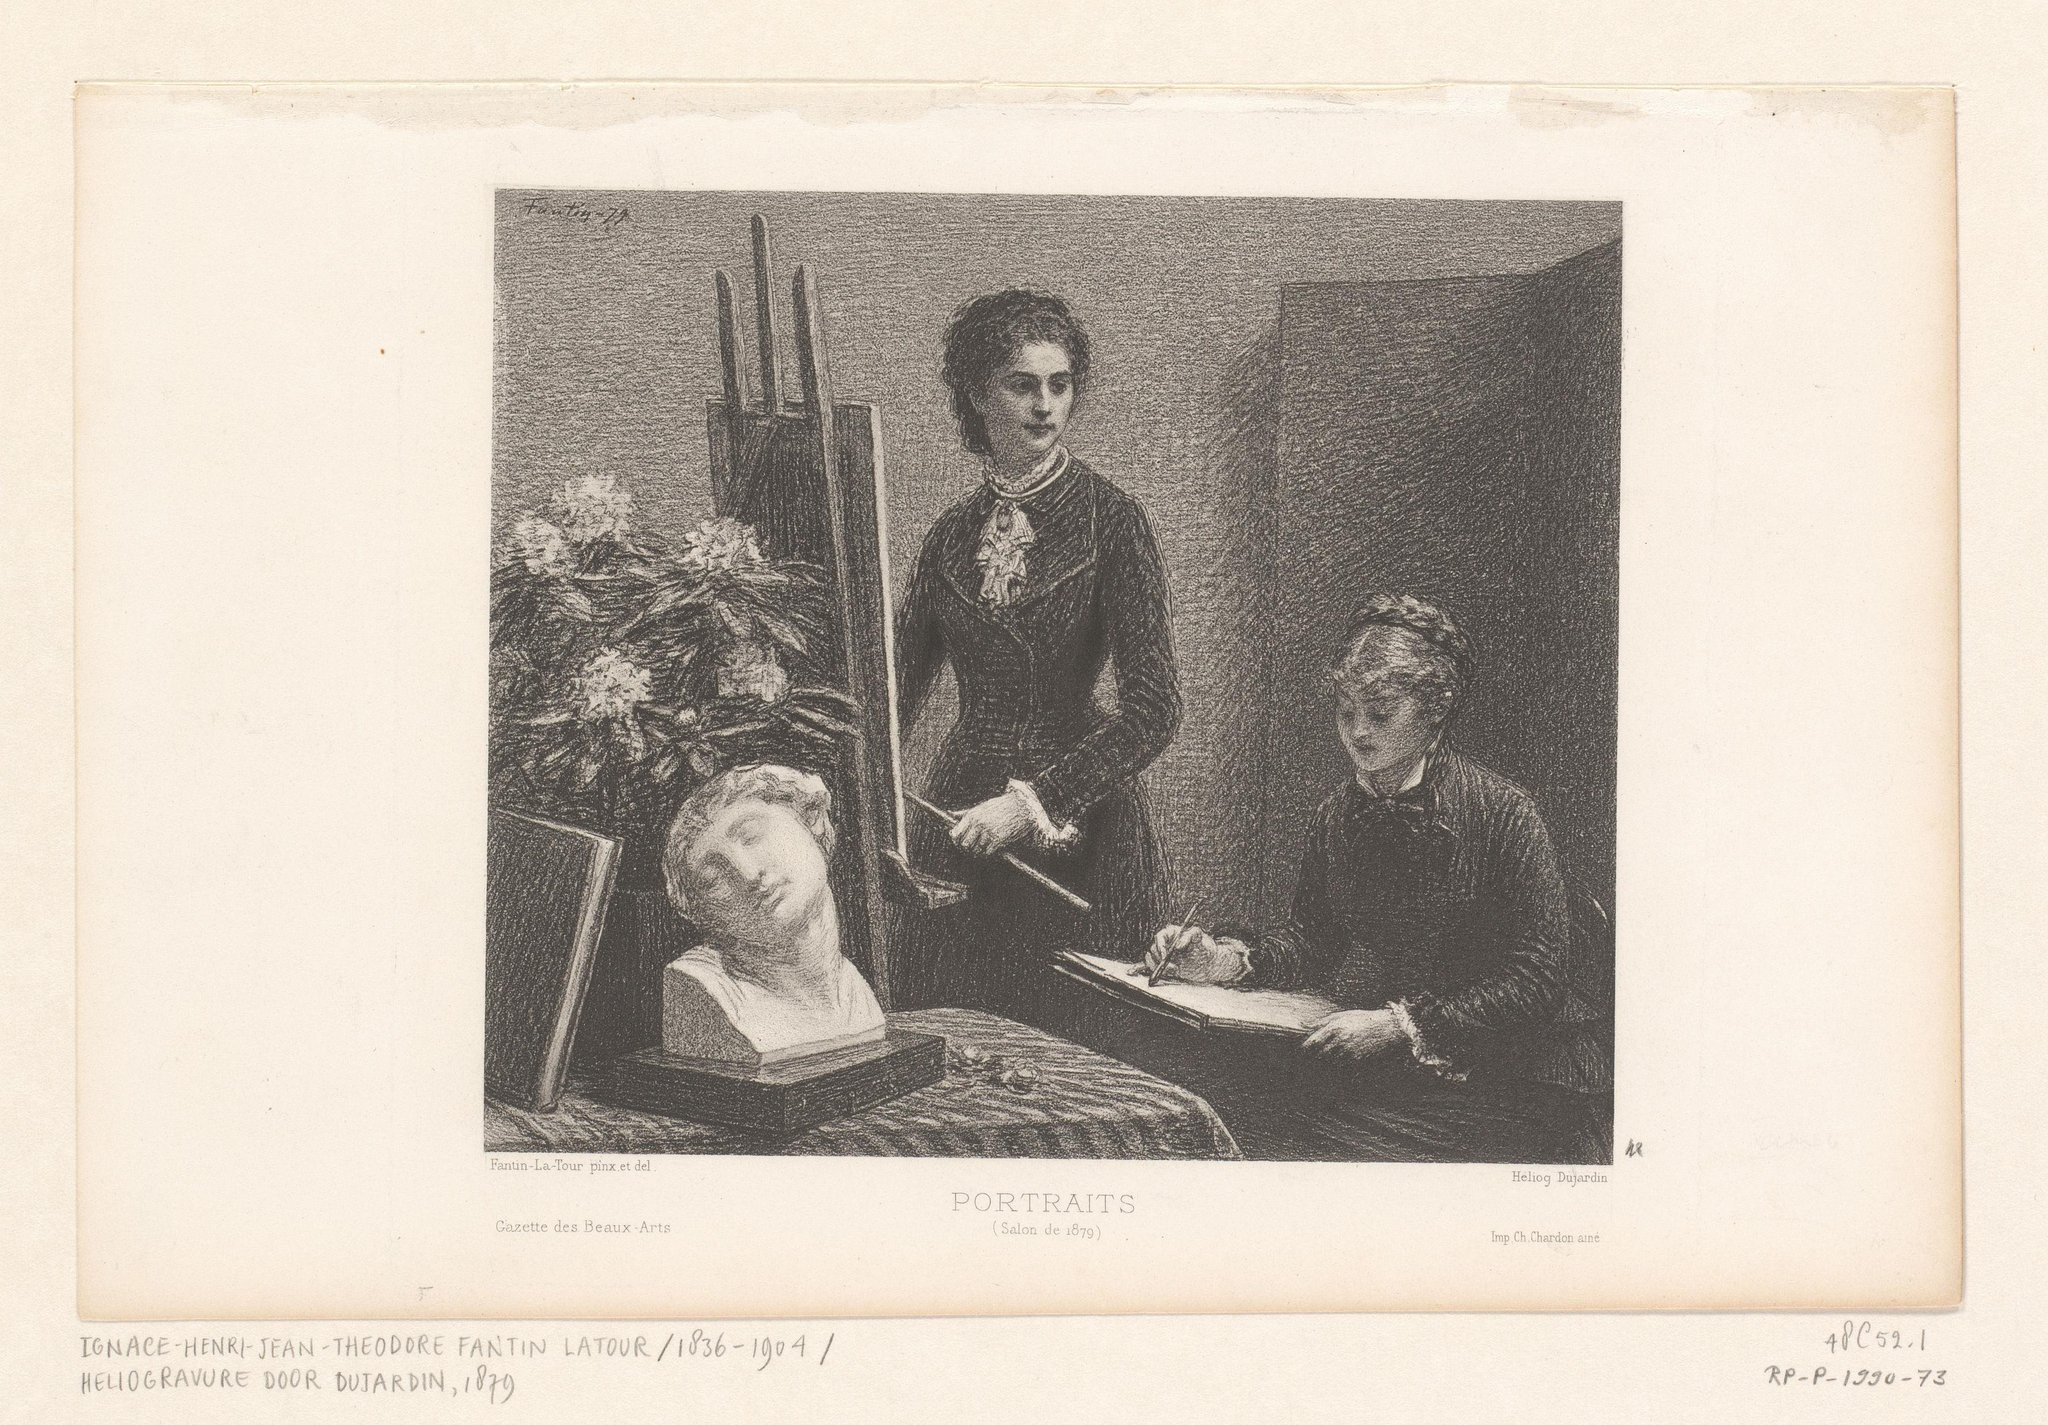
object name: photomechanical print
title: Portraits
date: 1879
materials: paper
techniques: photoaquatint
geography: paris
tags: draughtsman at work, piece of sculpture, reproduction of a piece of sculpture, easel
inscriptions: stamp: ‘ICON’, collector's mark: Lugt 2228a, inscription: ‘Gazette des Beaux-Arts/ (Salon de 1879)’, inscription: ‘469/14AP/HE/ 1410’